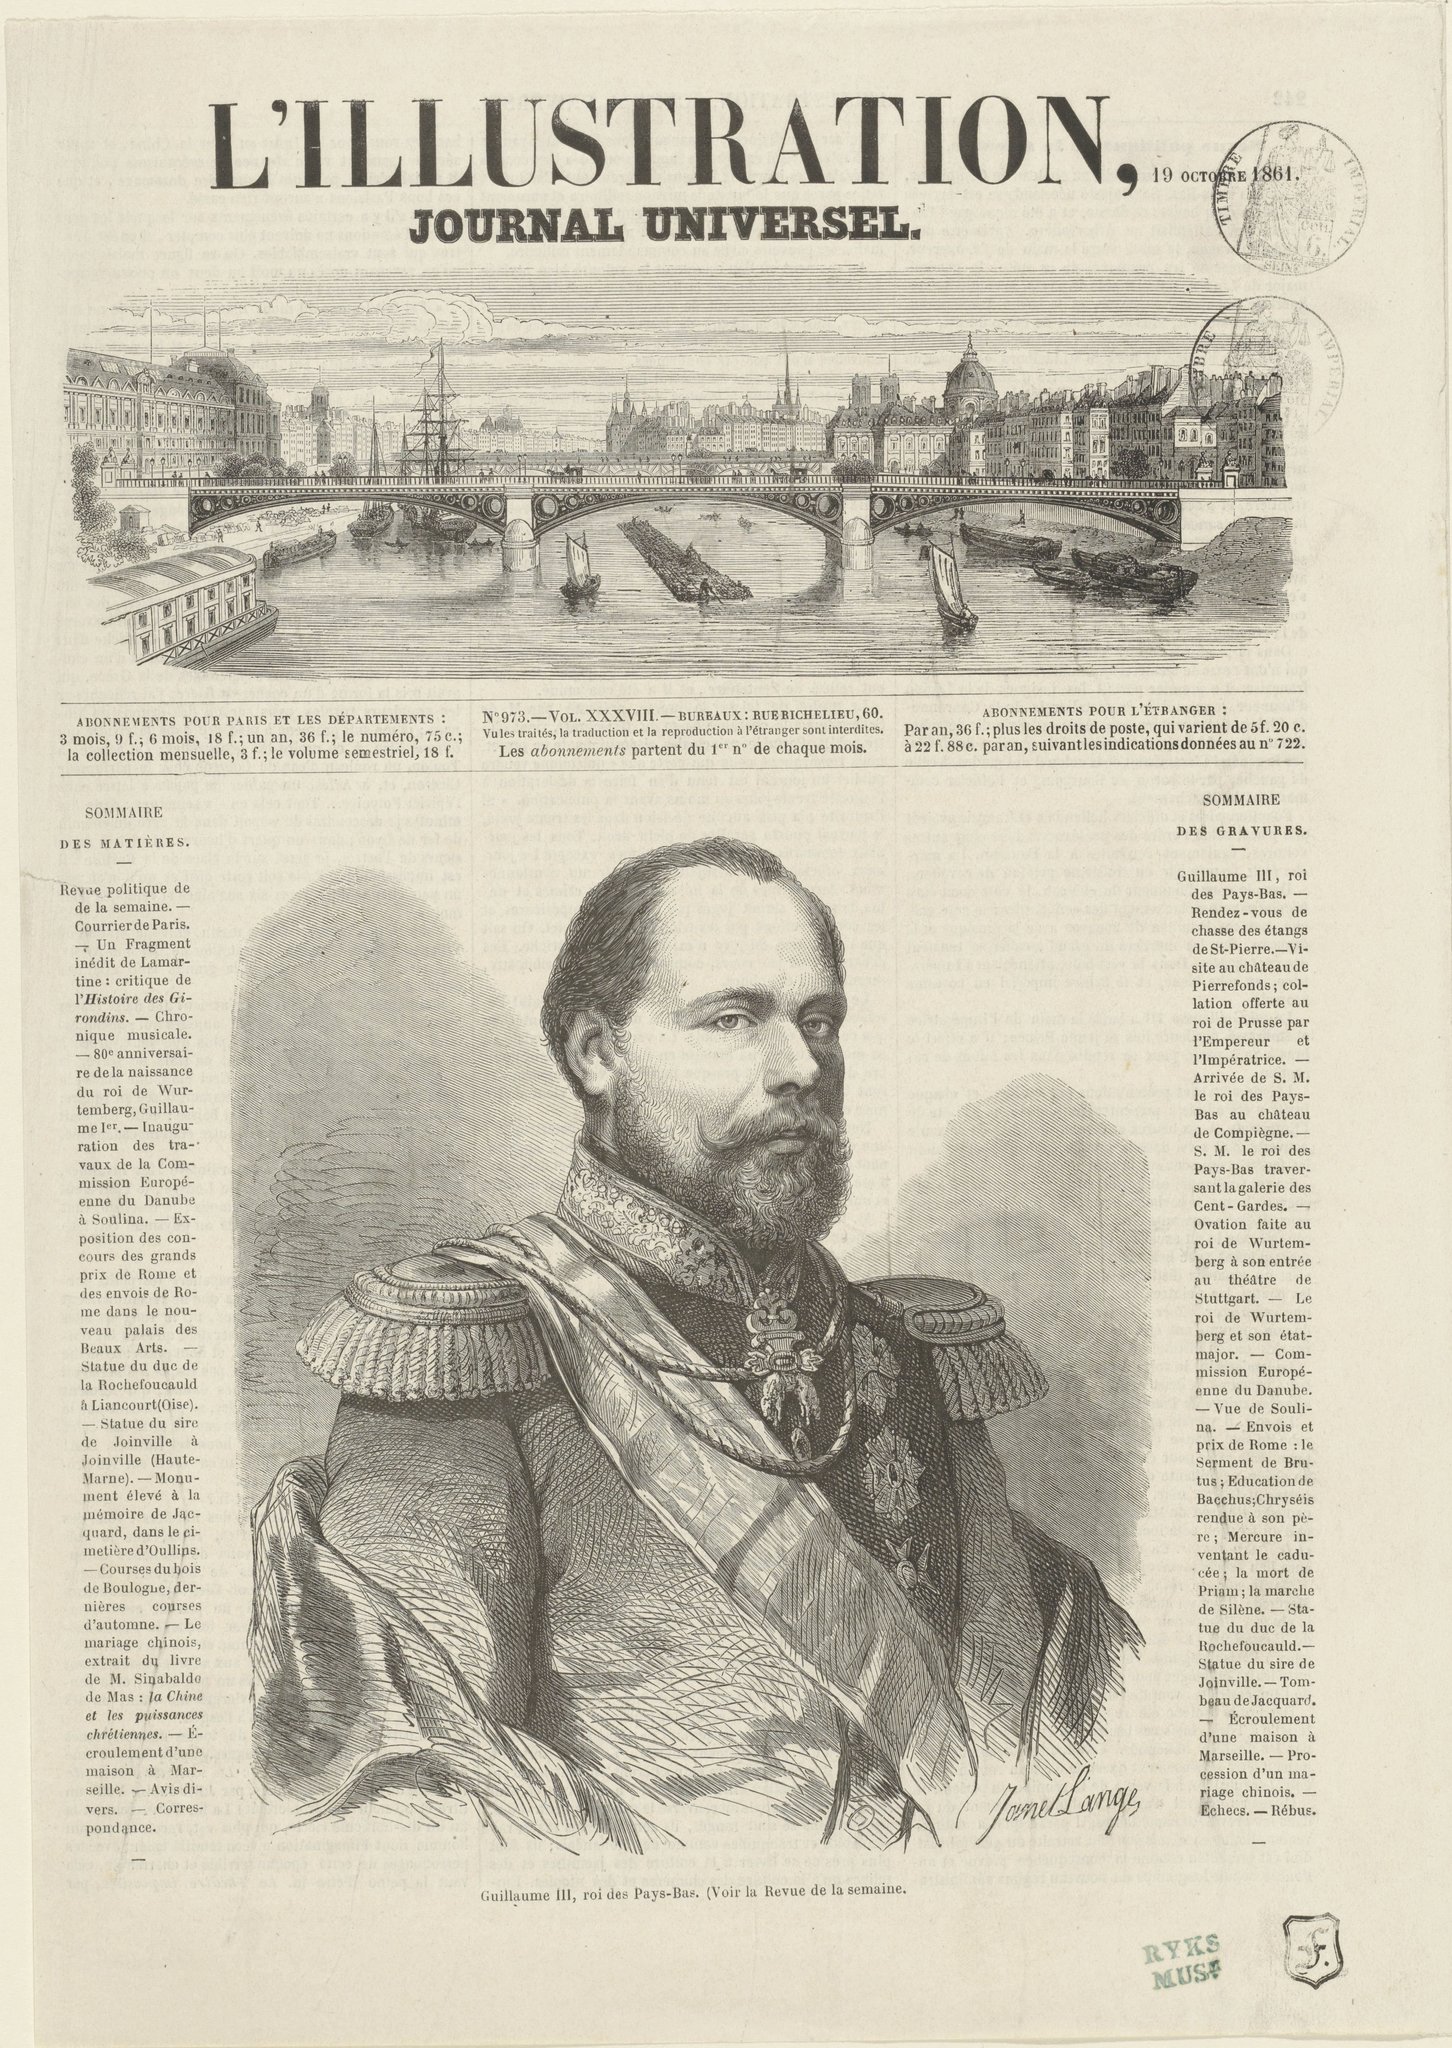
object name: newspaper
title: L'Illustration, Journal Universel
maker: ange-louis janet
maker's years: 1815-1872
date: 1861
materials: paper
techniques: letterpress printing, engraving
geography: paris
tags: brussels, willem iii (koning der nederlanden), knighthood order of the golden fleece - insignia of a knighthood order, e.g.: badge, chain (with name of order)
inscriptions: collector's mark: Lugt 2165, collector's mark: Lugt 963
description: Krant met een artikel over Willem III. In het midden een portret van Willem III. Daar omheen twee kolommen met Franse tekst in boekdruk. Midden boven een stadsgezicht.